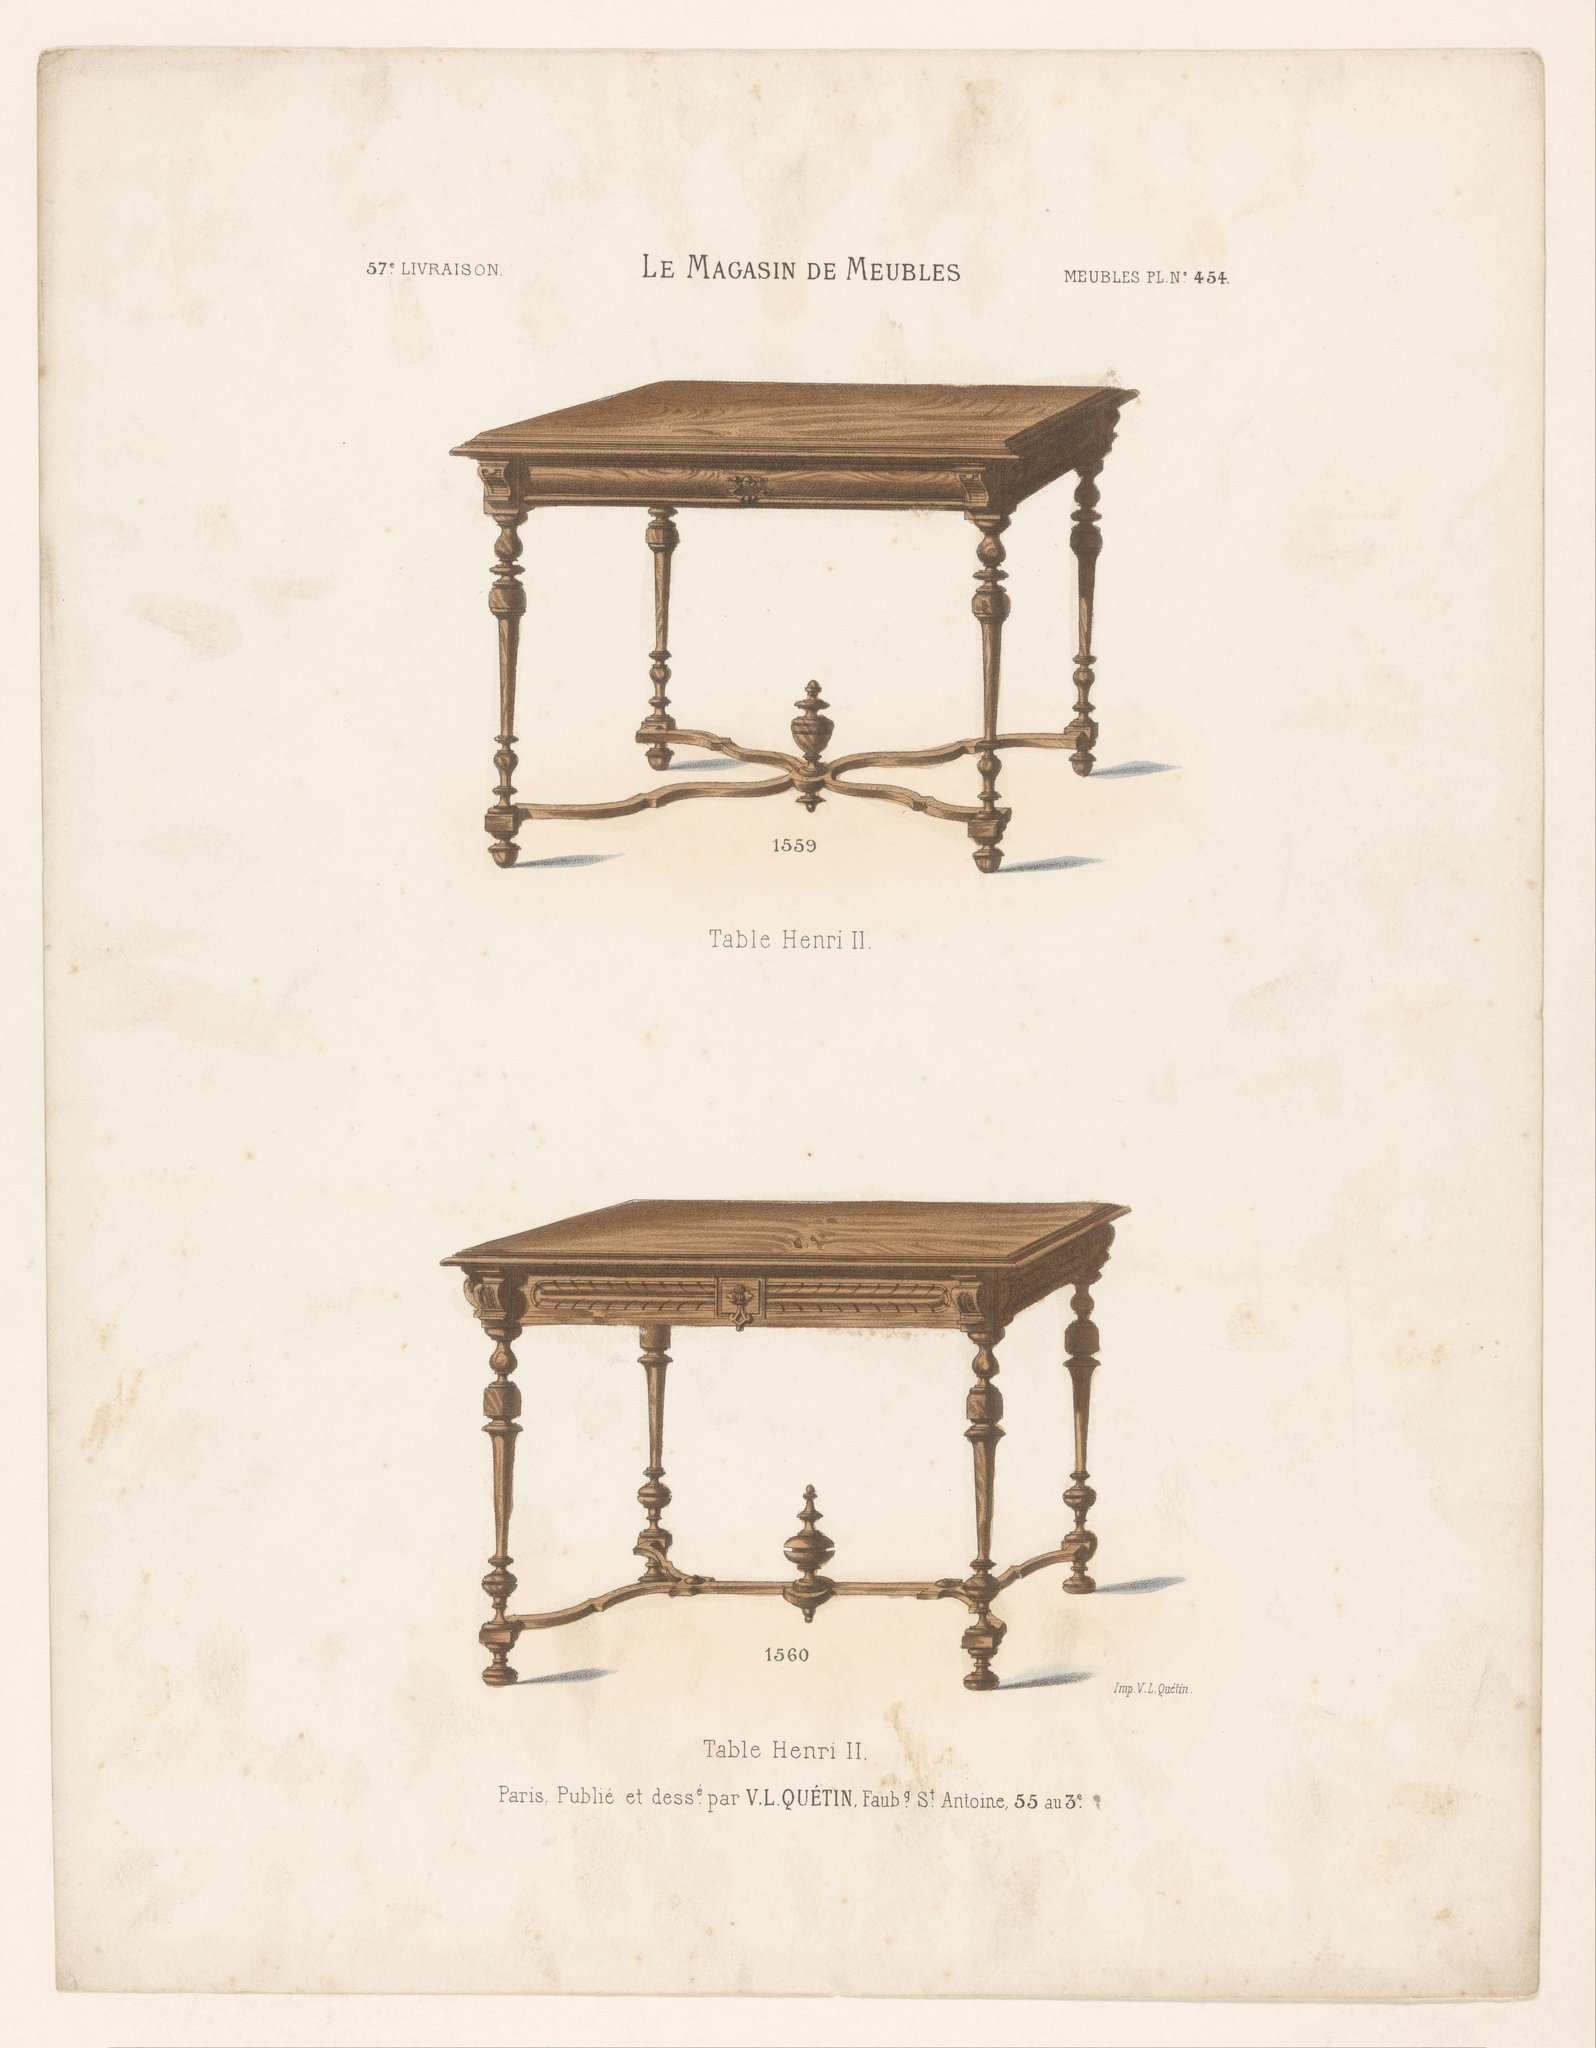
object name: print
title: Le Magasin de Meubles / Meubles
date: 1878-1904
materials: paper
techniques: hand coloring, lithograph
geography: paris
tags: table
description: Twee rechthoekige tafels in de Henrik II-stijl. Prent uit 57e Livraison.